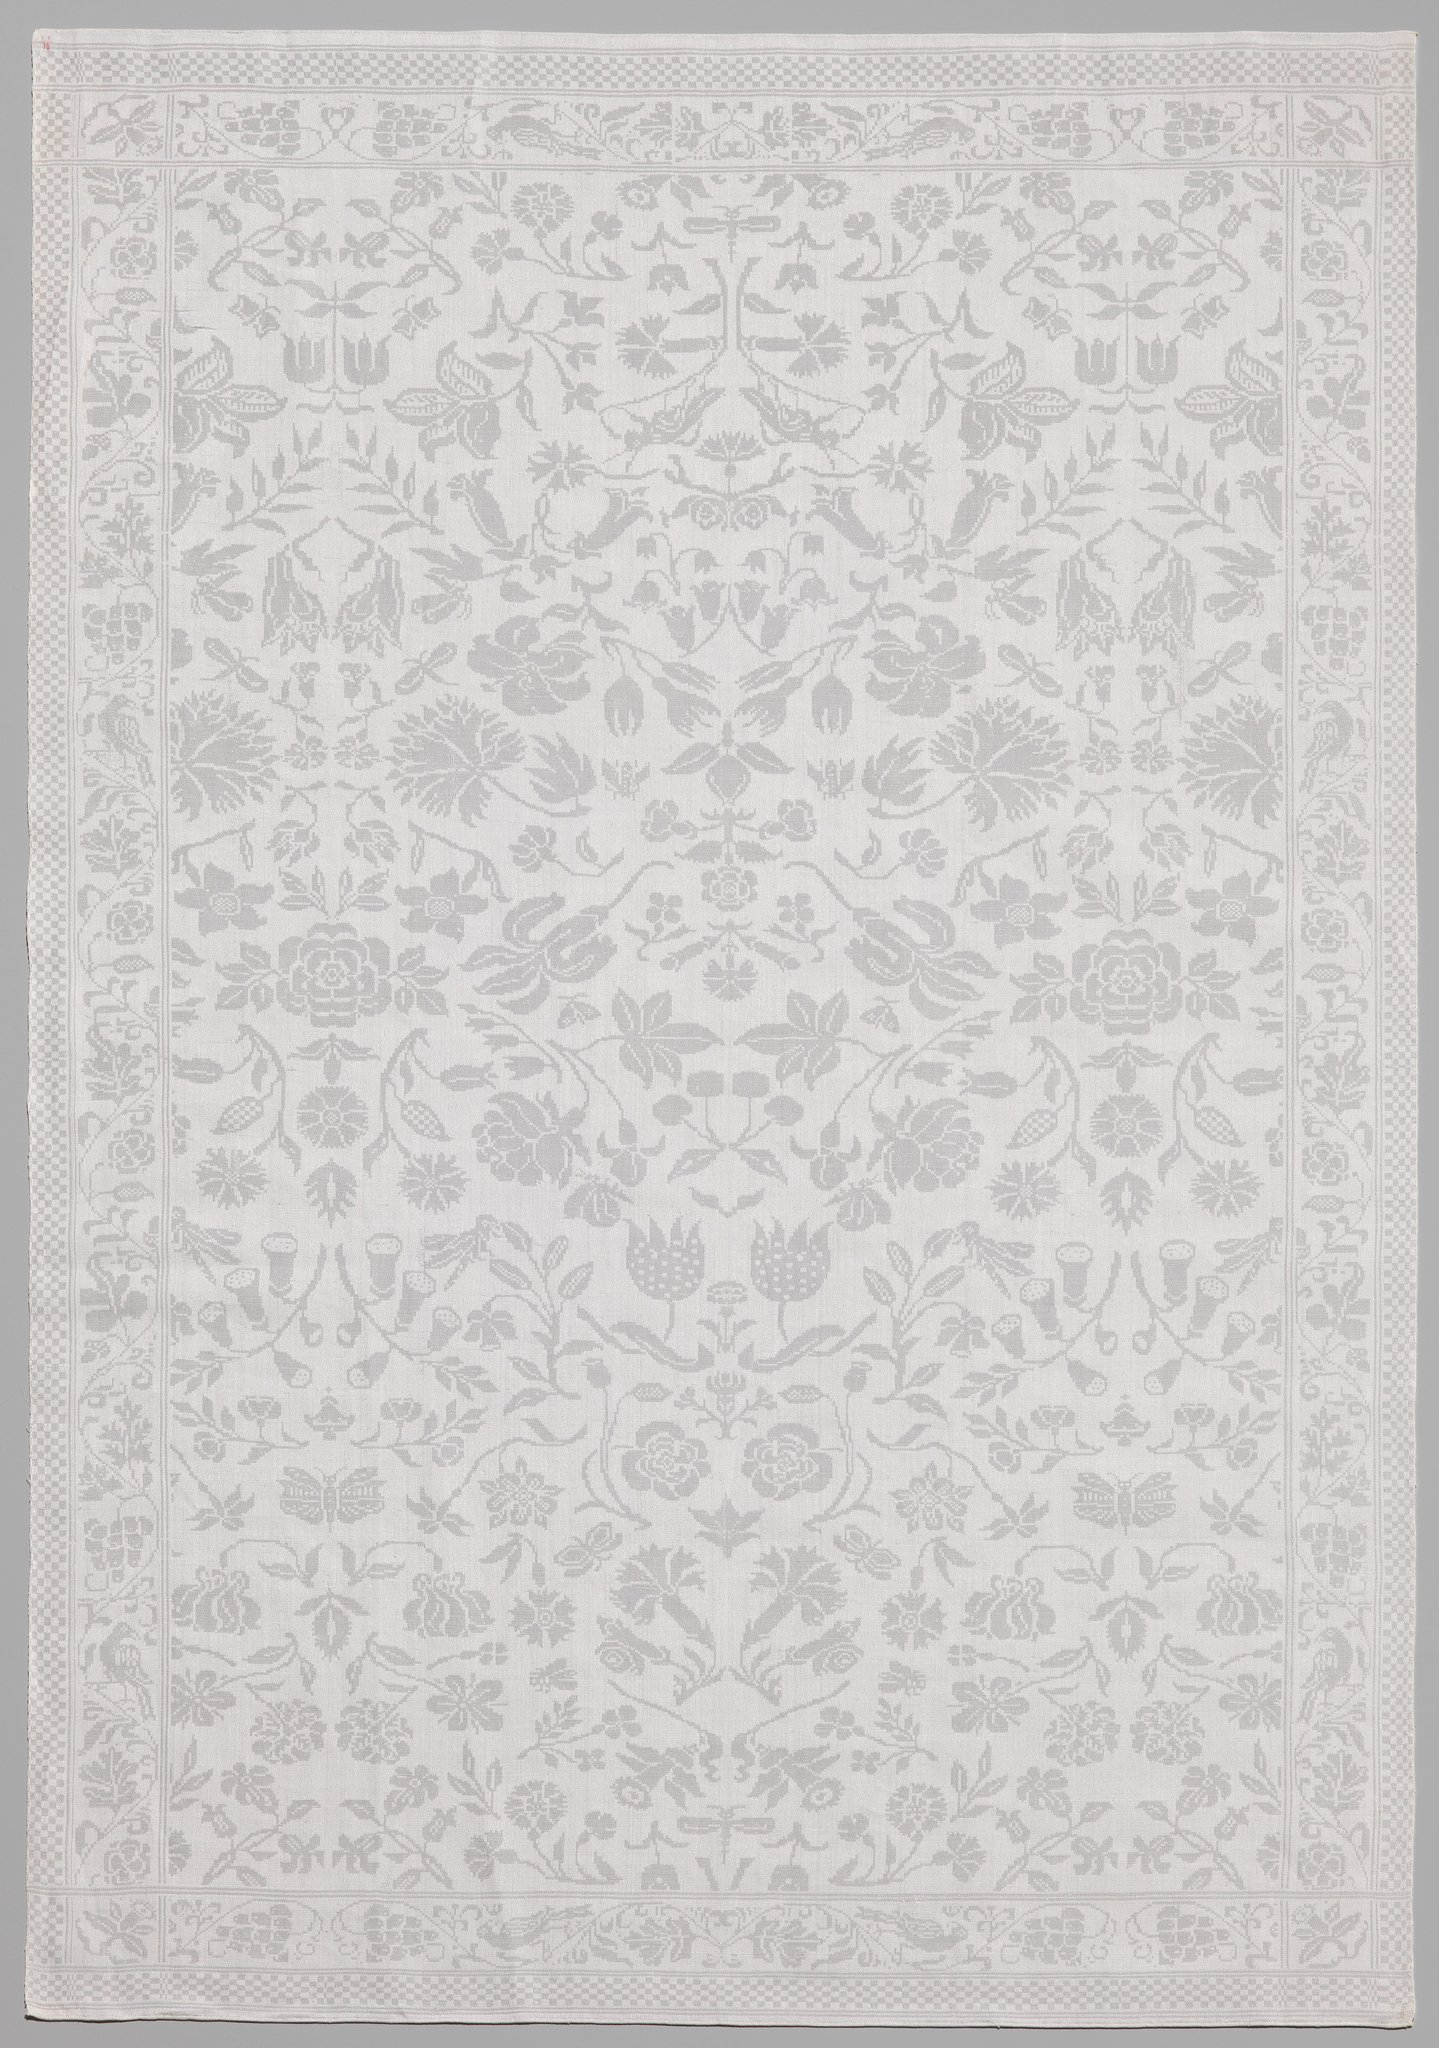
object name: napkin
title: Servet met patroon van strooibloemen, kersen, insecten waaronder sprinkhaan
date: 1640-1660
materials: linen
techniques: damask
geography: netherlands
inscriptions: mark: ‘D of O’, mark: ‘LS 18’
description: Wit linnen damasten servet met gestrooide bloemen, kersen, sprinkhaan, en andere insecten.